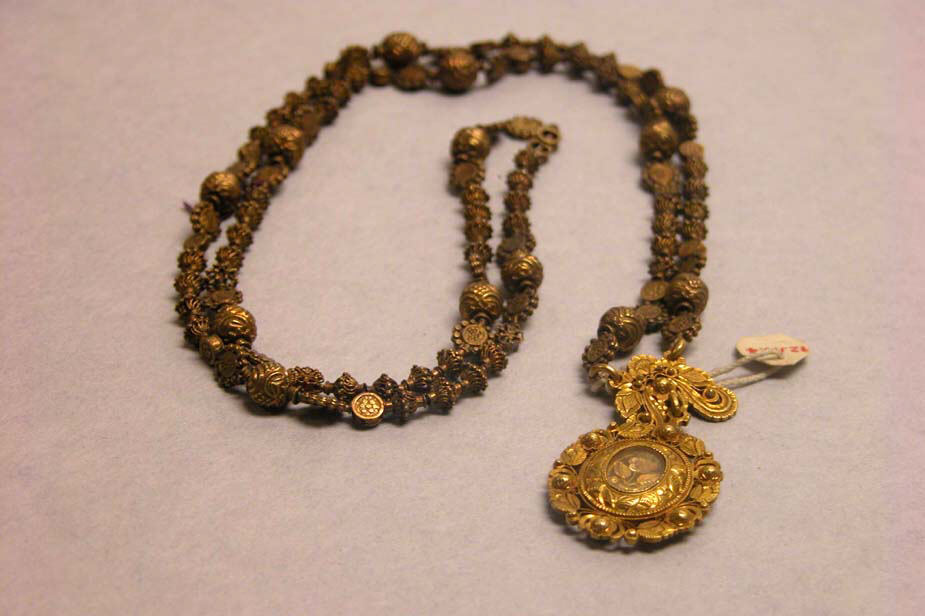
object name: rosary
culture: filipino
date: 1601-1900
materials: gold